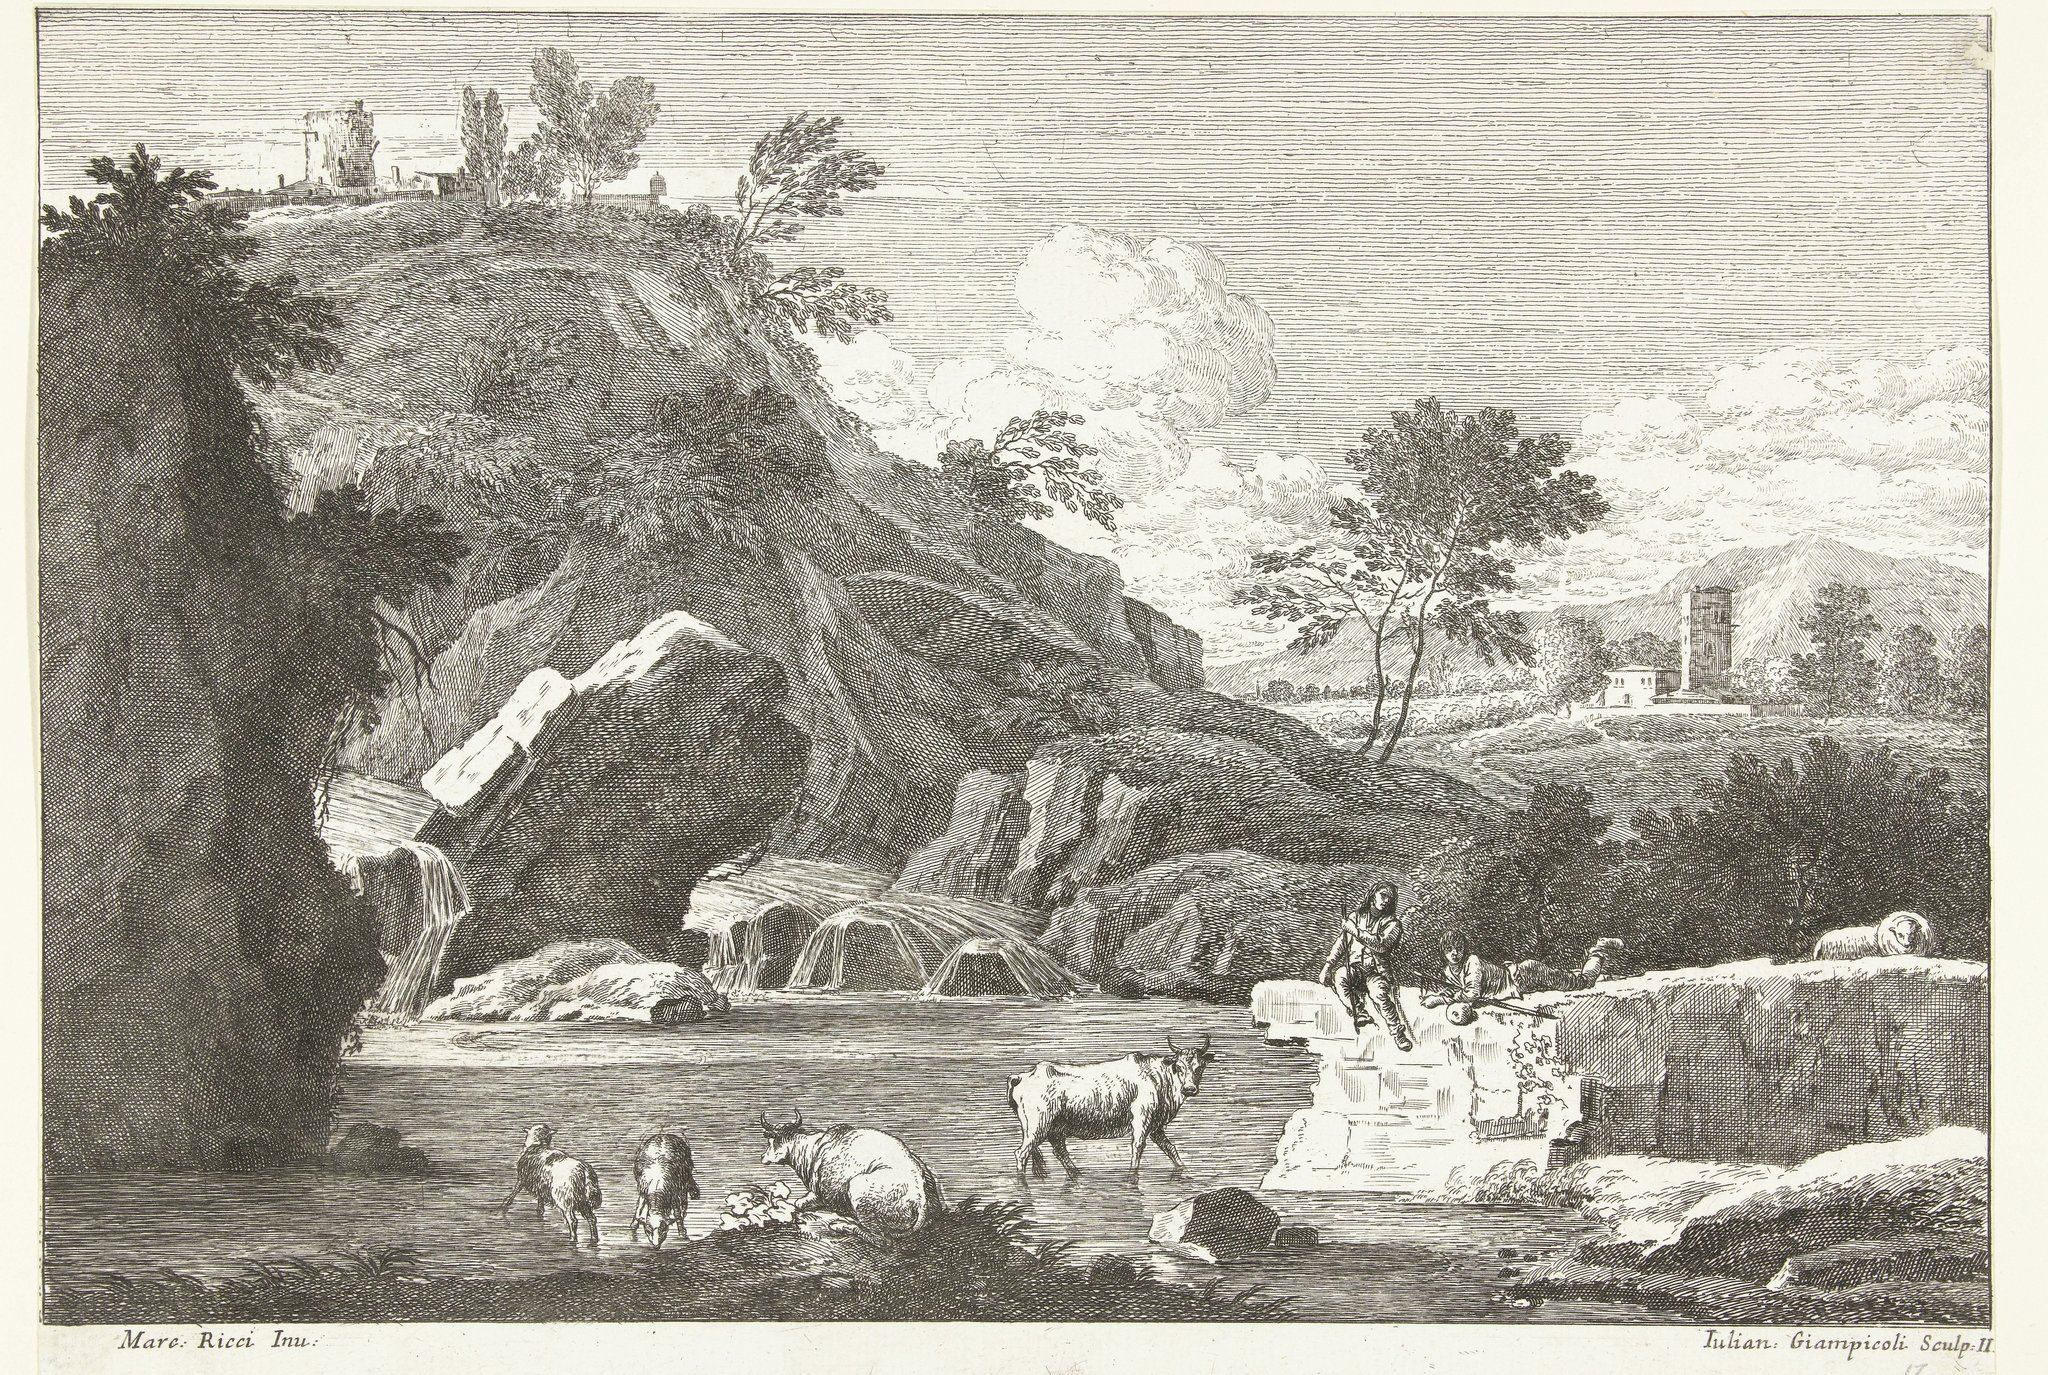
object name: print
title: Italiaanse landschappen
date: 1739-1740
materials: paper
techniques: etching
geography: venice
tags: herding, herdsman, herdswoman, shepherd, shepherdess, cowherd, etc., waterfall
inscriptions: collector's mark: Lugt 2228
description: Prent uit tweede serie van negentien prenten met achttien Italiaanse landschappen naar ontwerp van Marco Ricci en titelprent (zie RP-P-1952-1). Tweede serie is opgedragen aan Antonio Maria Zanetti. De serie in de collectie van het RMA is gedrukt in de eerste staat voor vermelding van de uitgever Teodoro Viero. Het serienummer 17 is van het blad afgesneden.